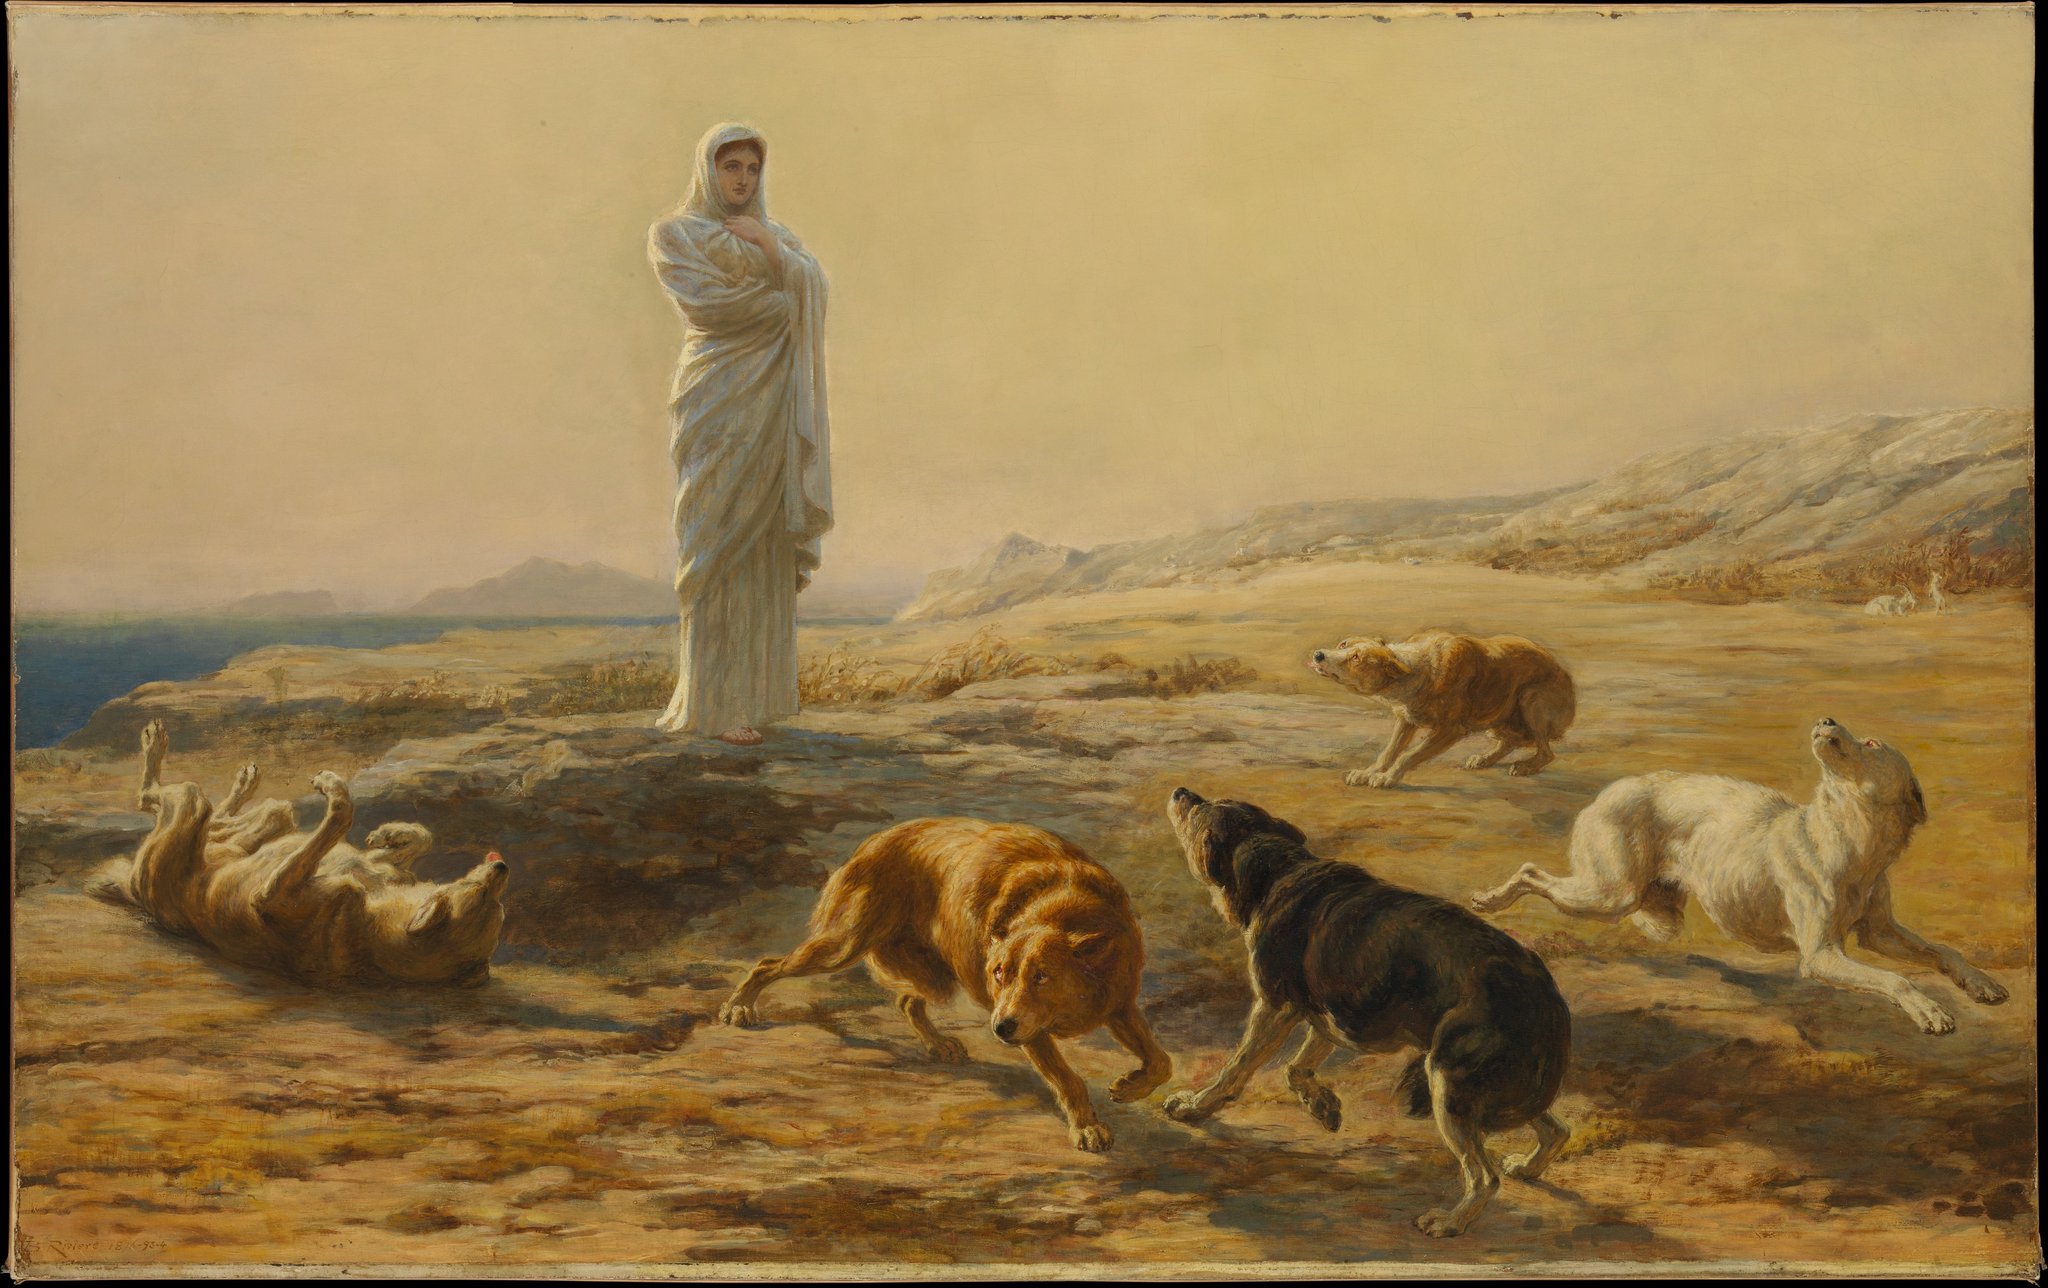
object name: painting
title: Pallas Athena and the Herdsman's Dogs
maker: briton riviere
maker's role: artist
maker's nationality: british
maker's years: 1840-1920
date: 1876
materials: canvas, oil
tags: athena,dogs